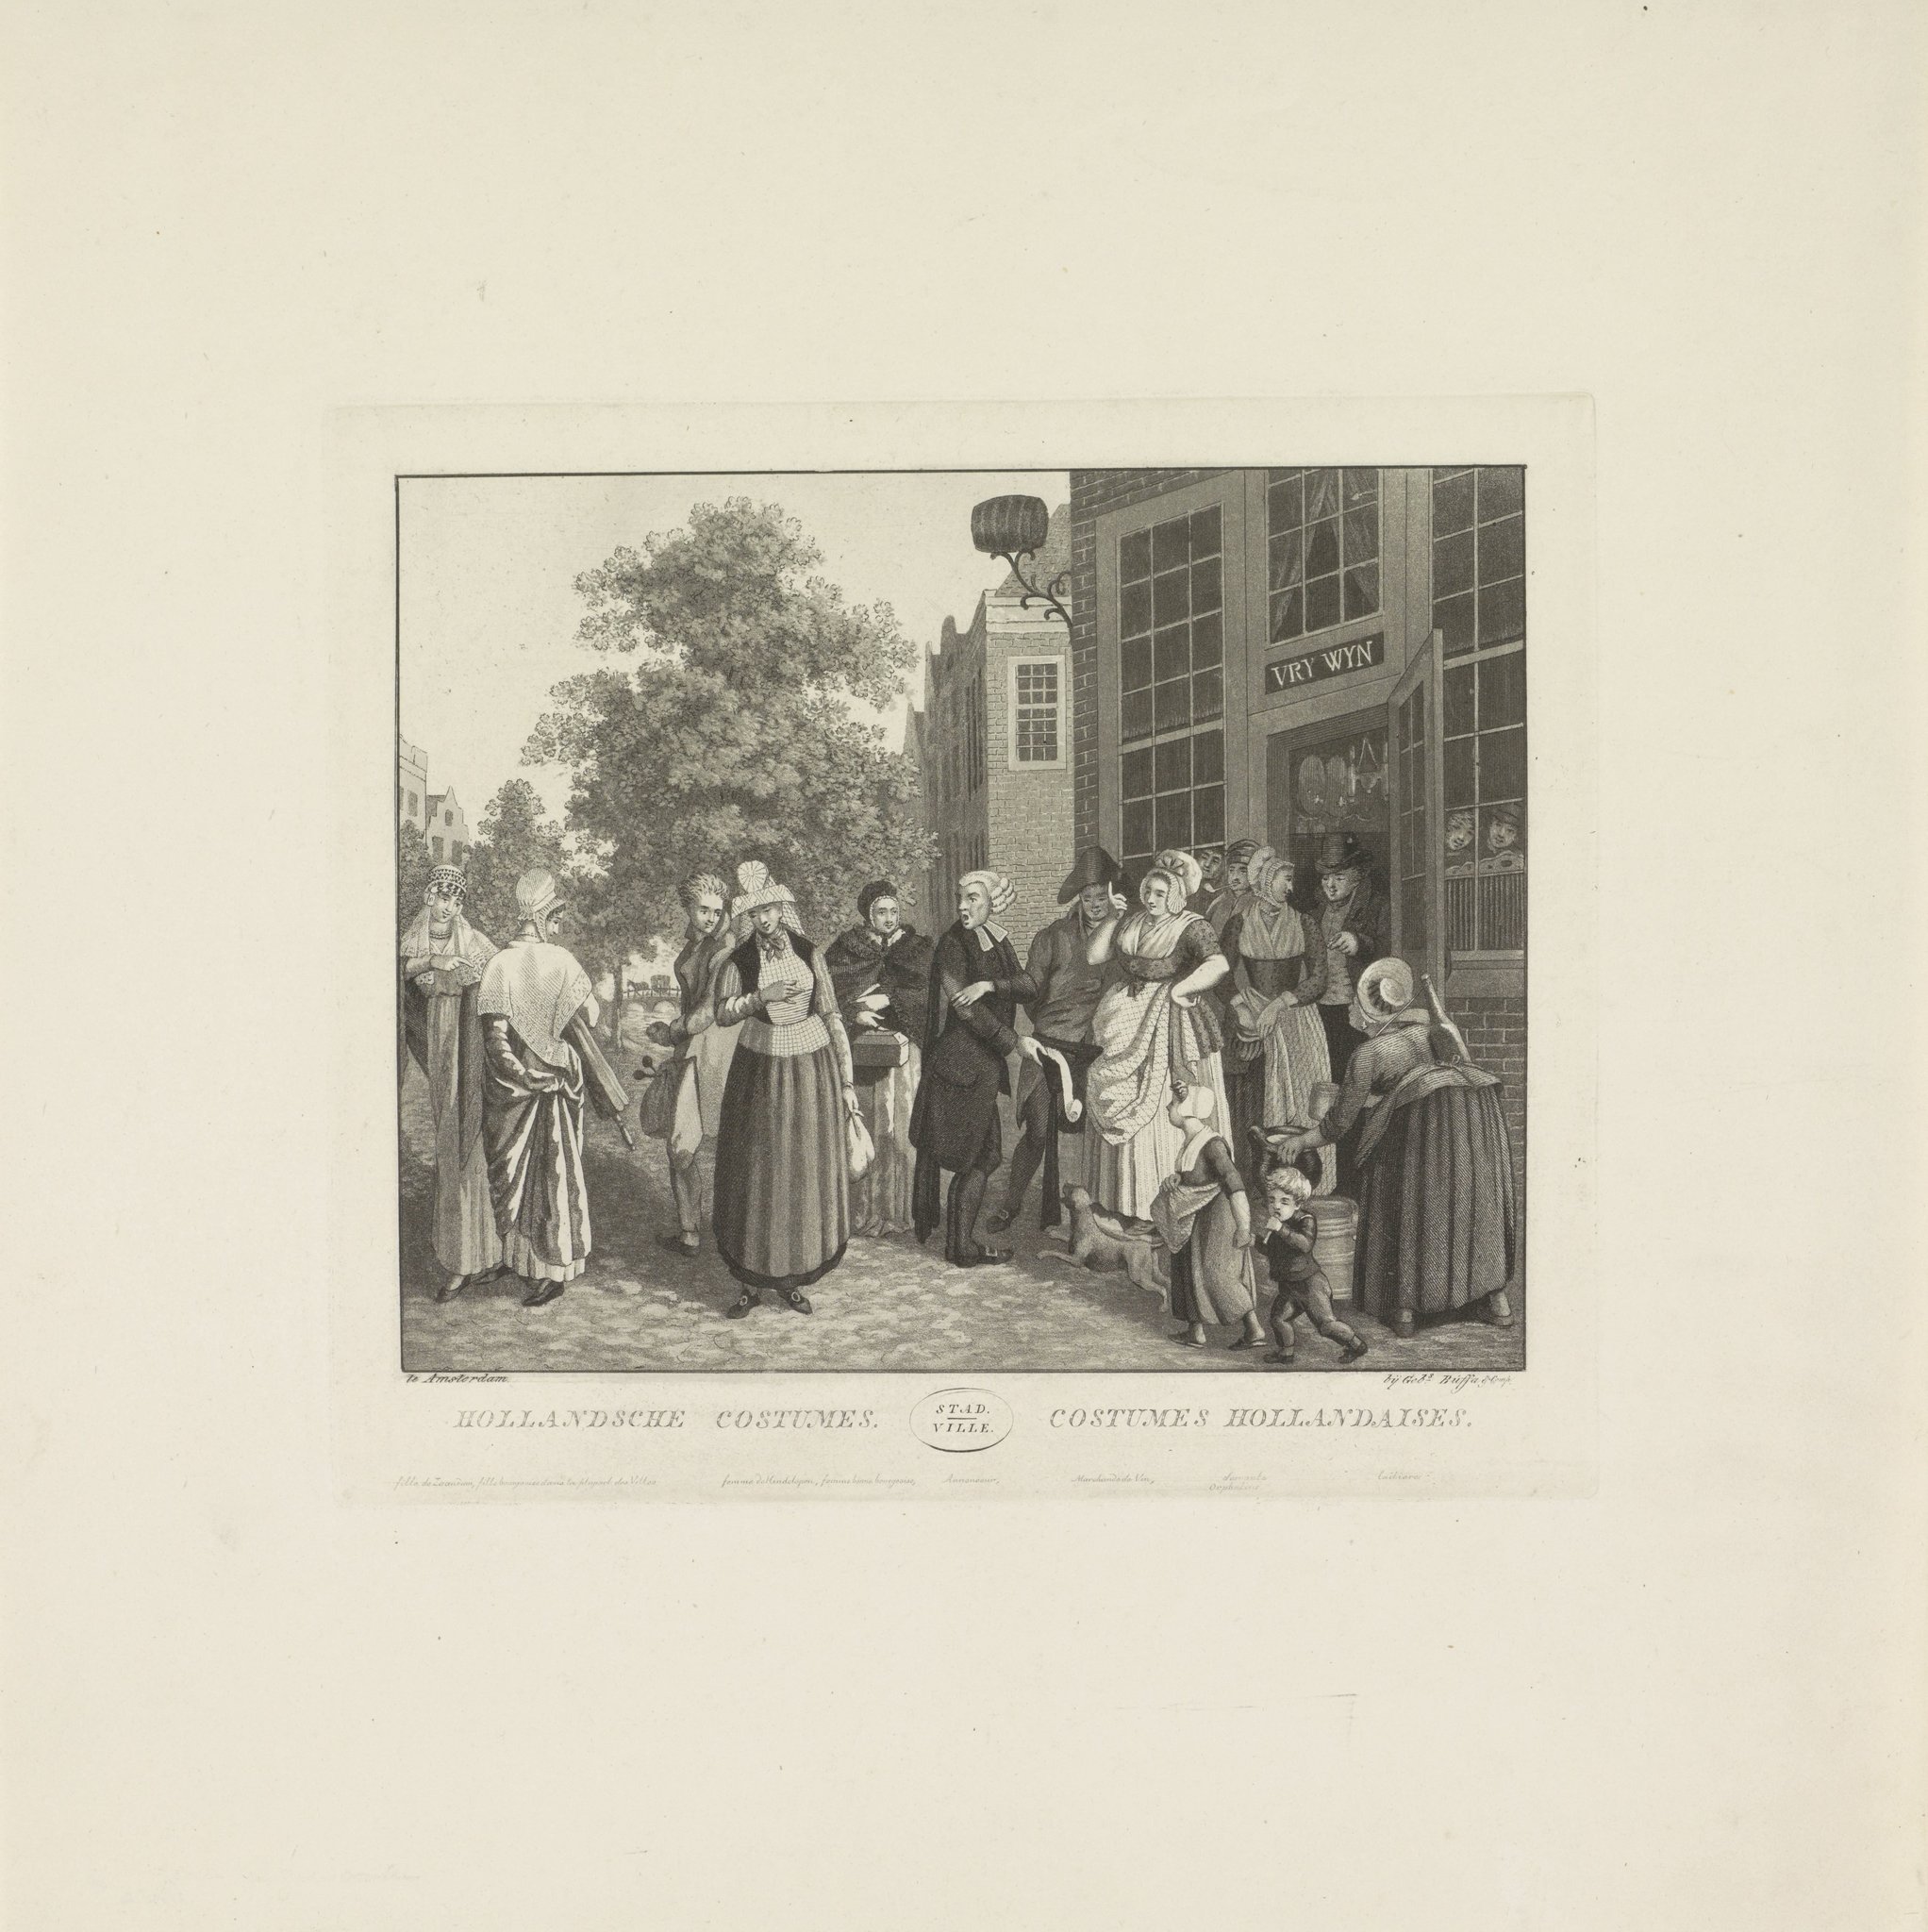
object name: costume print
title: Hollandsche Costumes. Stad/Ville. Costumes Hollandaises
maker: ludwig gottlieb portman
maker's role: print maker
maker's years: 1772-1828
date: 1820-1830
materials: paper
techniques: aquatint, etching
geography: amsterdam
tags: oral announcement (of death), undertaker's man, professional clothes, inn, coffee-house, public house, etc., folk costume, regional costume, milkmaid, orphans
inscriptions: collector's mark: Lugt 2228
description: Twaalf personen in klederdracht van verschillende steden, op straat voor een stadsherberg, ca. 1820-1830. Volgens de opschriften onder de titel gaat het om vrouwen uit de plaatsen Zaandam en Hindeloopen, een vrouw uit de gegoede burgerij en andere personen met de beroepen van aanspreker, wijnverkoper, dienstmeid en melkmeid. De twee kinderen aangeduid als wezen. Zie ook de pendant.